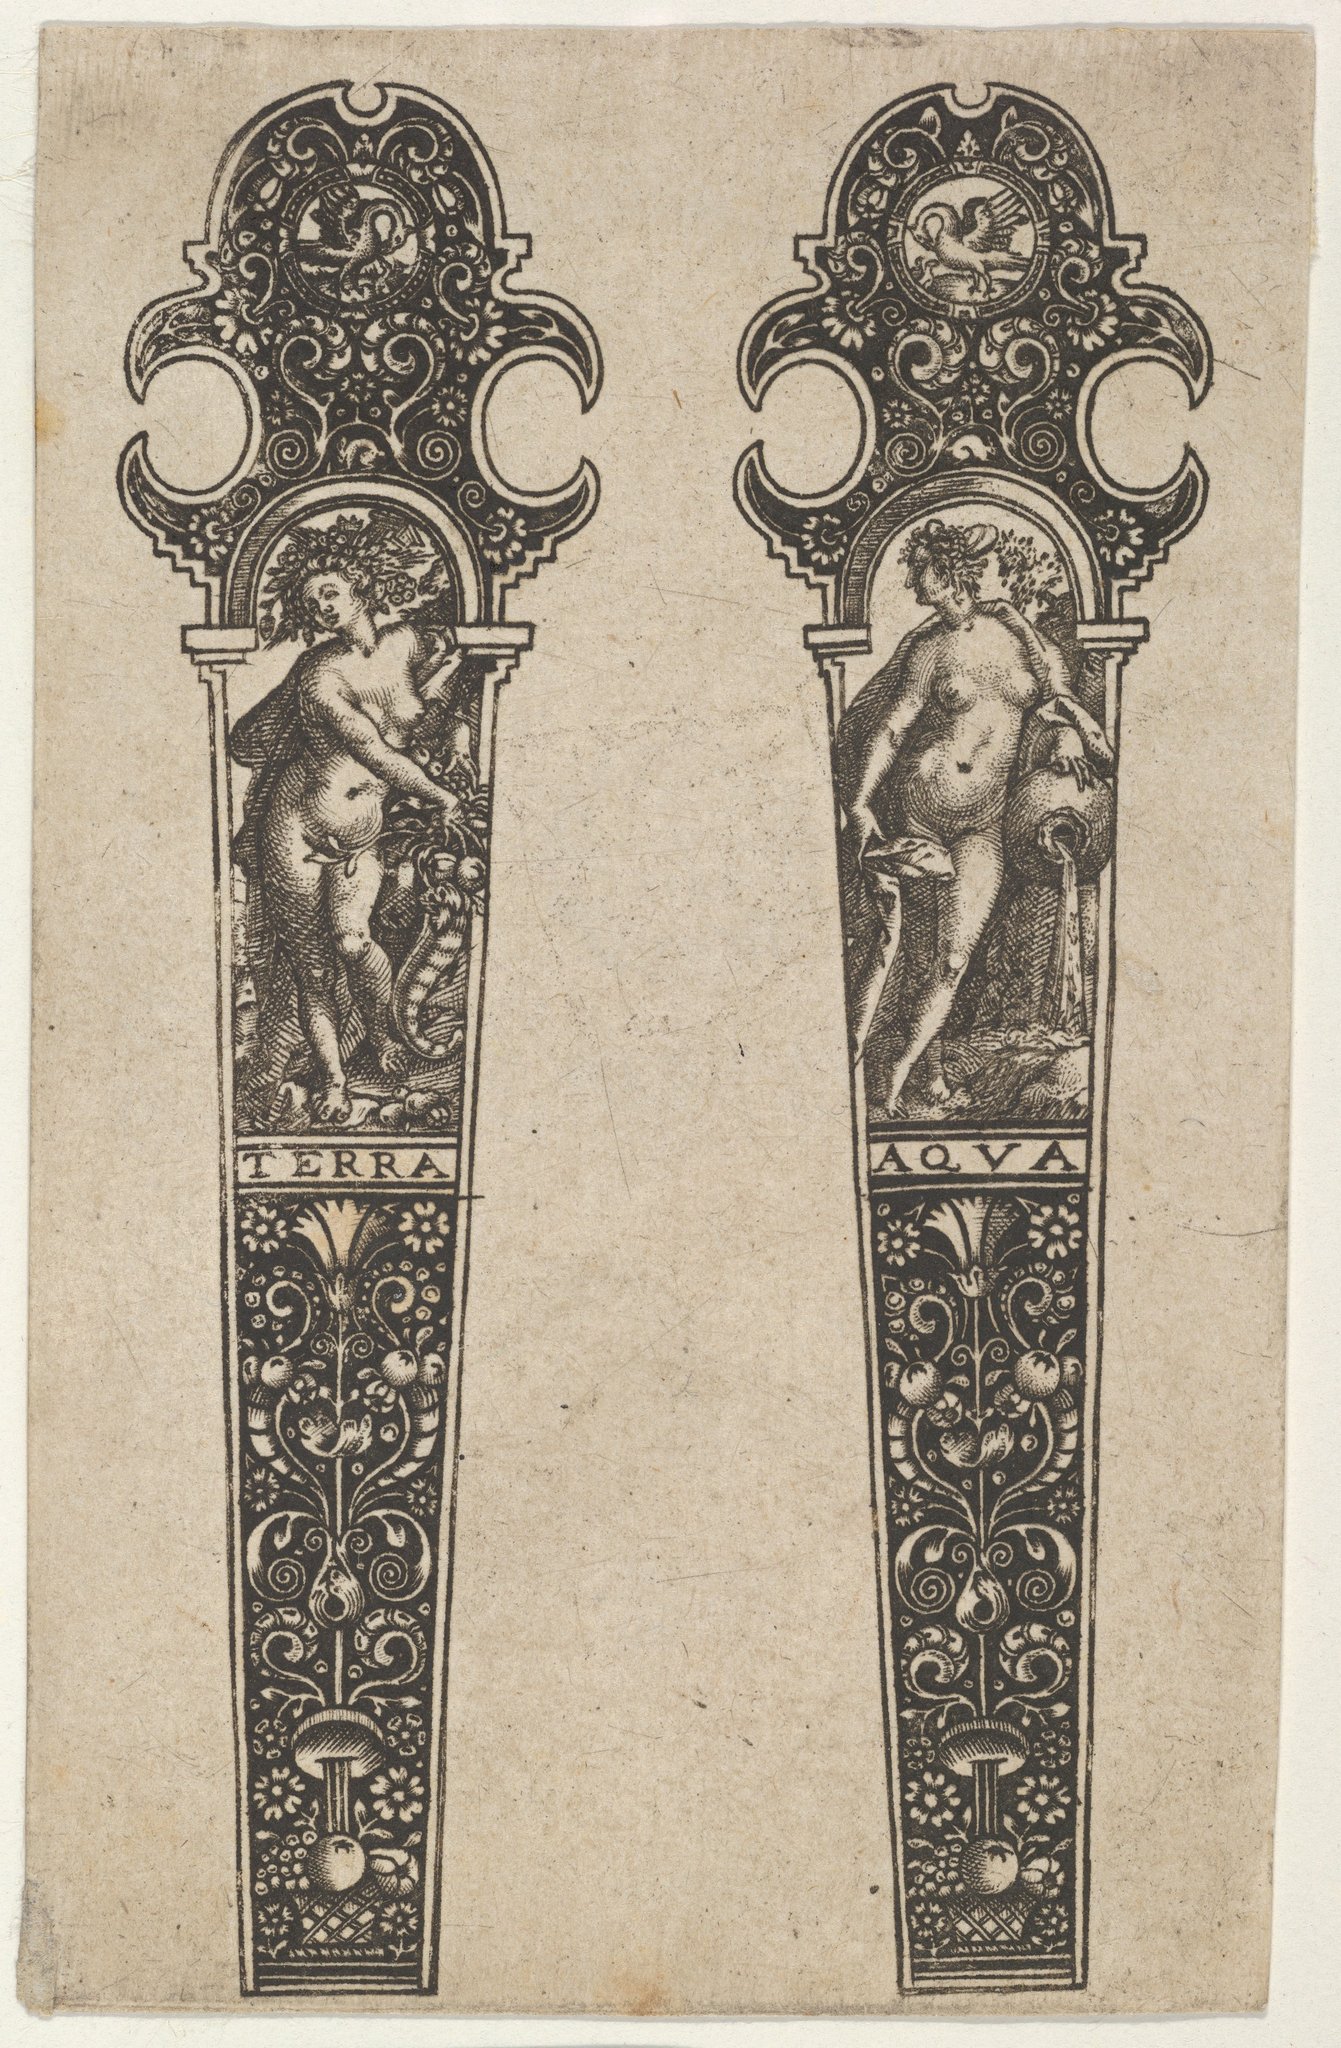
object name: print ornament architecture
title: Design for Knife Handles with Terra and Aqua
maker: johann theodor de bry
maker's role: artist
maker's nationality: netherlandish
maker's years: 1561-1623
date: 1580-1600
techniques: embroidery, engraving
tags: knives